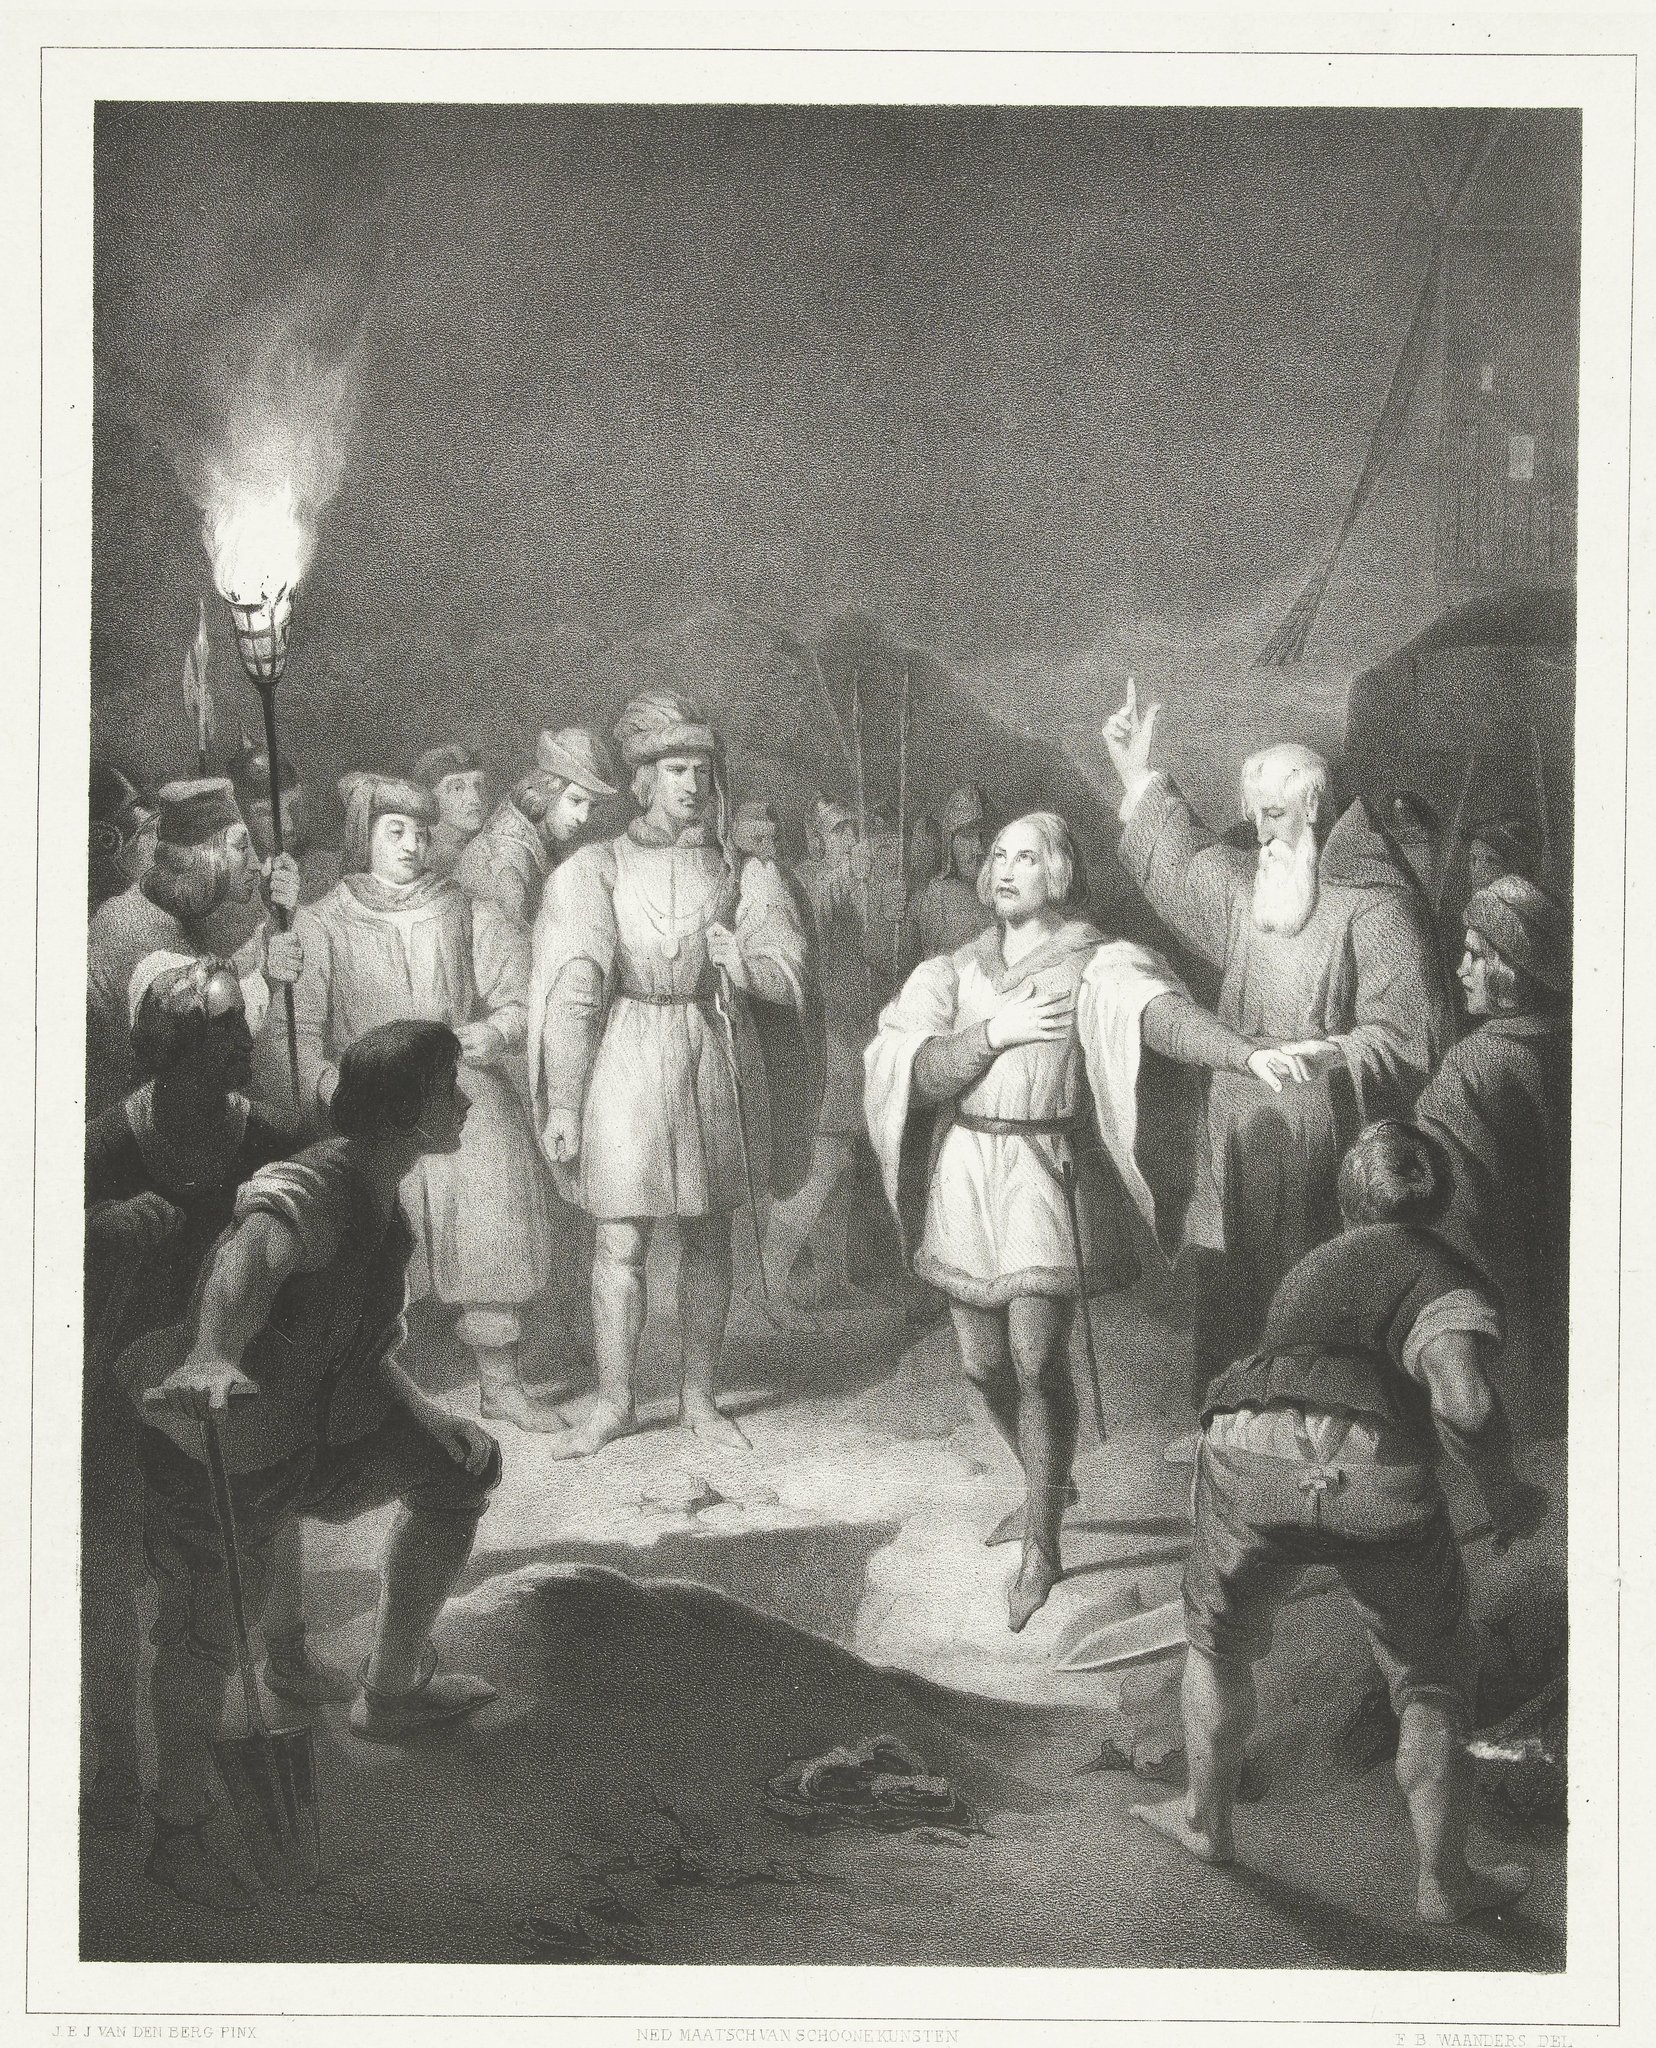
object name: print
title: Albert Beiling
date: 1841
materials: paper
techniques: lithograph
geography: netherlands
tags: jacoba of bavaria (countess of hainaut), on the scaffold or place of execution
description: Illustratie voor: Neerlands eerezuil of geschiedkundige tafereelen van Neerlands roemruchtige daden door de voornaamste nederlandsche kunstenaars, Nederlandsche maatschappij van schoone kunsten, ’s-Gravenhage 1841. Zonder de bij Muller vermelde uitvoerige historische beschrijving.